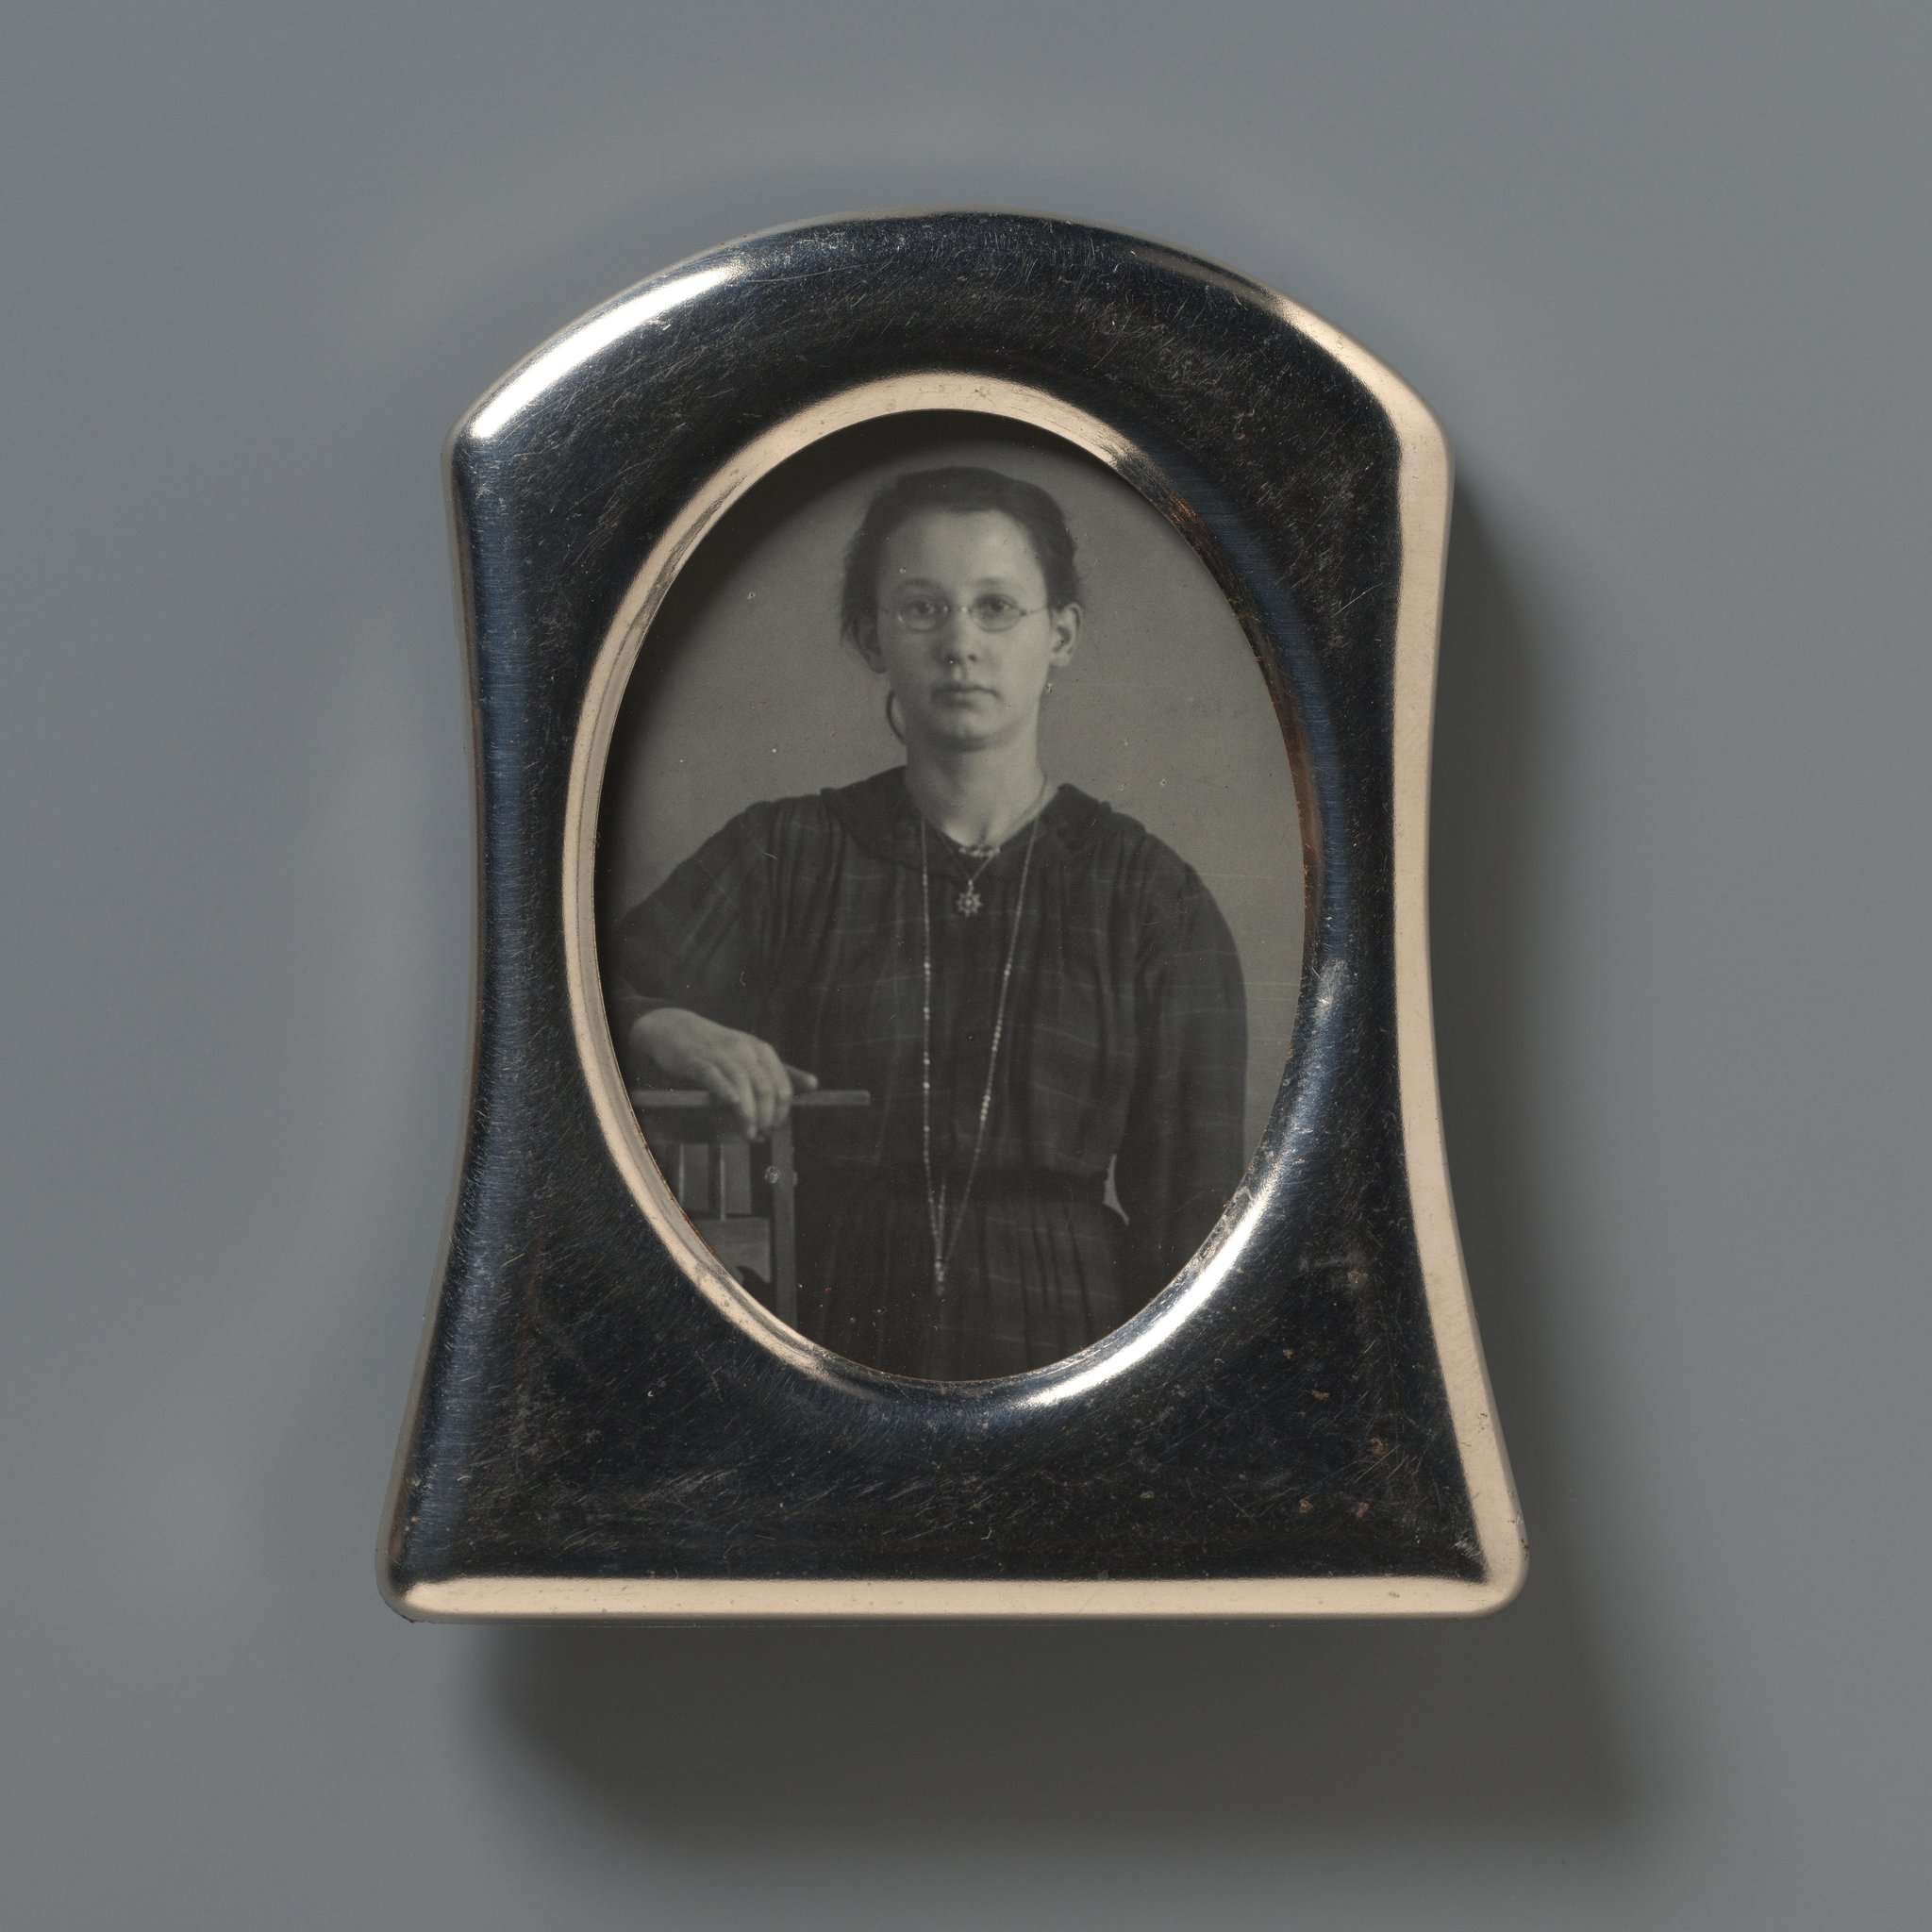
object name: photograph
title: Portret van een onbekende jonge vrouw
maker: Anonymous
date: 1900-1920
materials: paper, glass, metal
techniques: gelatin silver print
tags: anonymous historical person portrayed - bb - woman